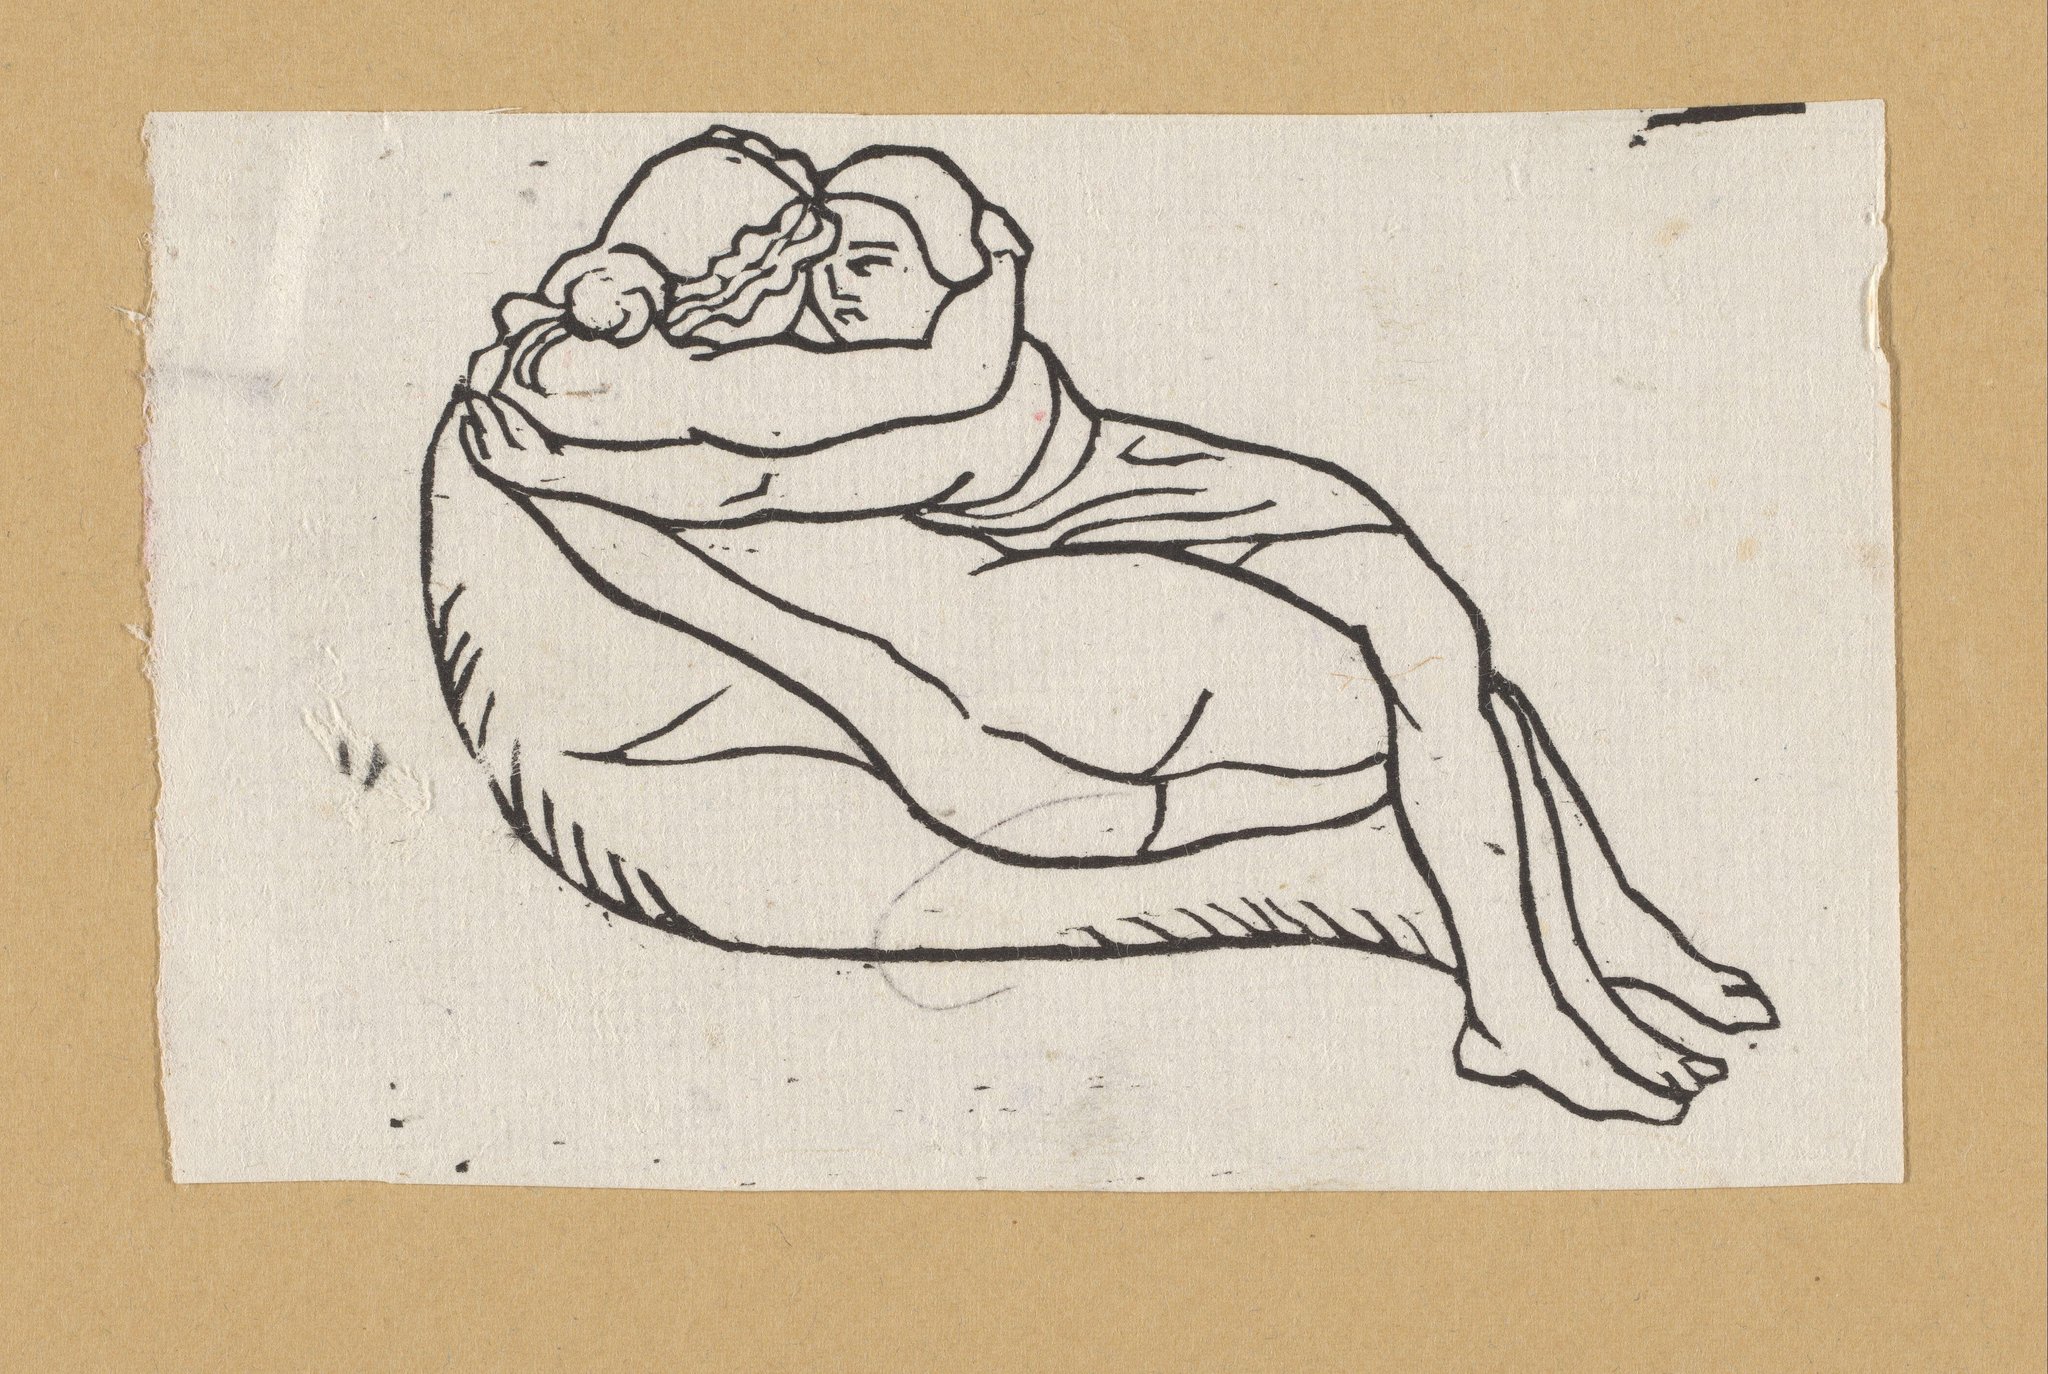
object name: book illustration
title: Daphnis et Chloé couchés ensemble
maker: aristide maillol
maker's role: draughtsman, painter, print maker, sculptor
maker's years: 1861-1944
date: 1937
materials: paper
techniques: woodcut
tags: daphnis (in greek mythology a shepherd who invented pastoral poetry, chloe, couple of lovers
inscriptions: collector's mark: Lugt 2228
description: Deze prent werd ontworpen als boekillustratie, maar nooit gebruikt in: Longus. Les Pastorales de Longus ou Daphnis & Chloé. Parijs: Frères Gonin, 1935.